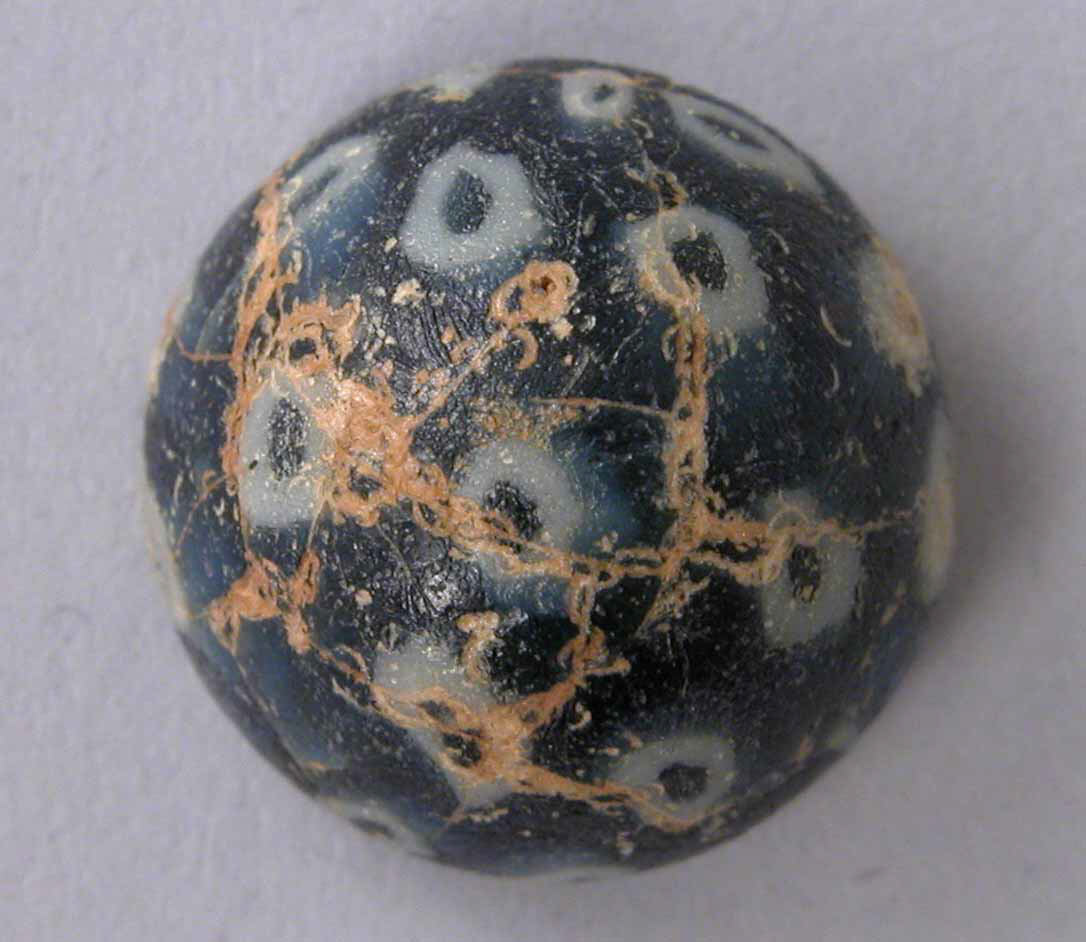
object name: gaming piece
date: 701-1200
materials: glass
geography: islamic lands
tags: games